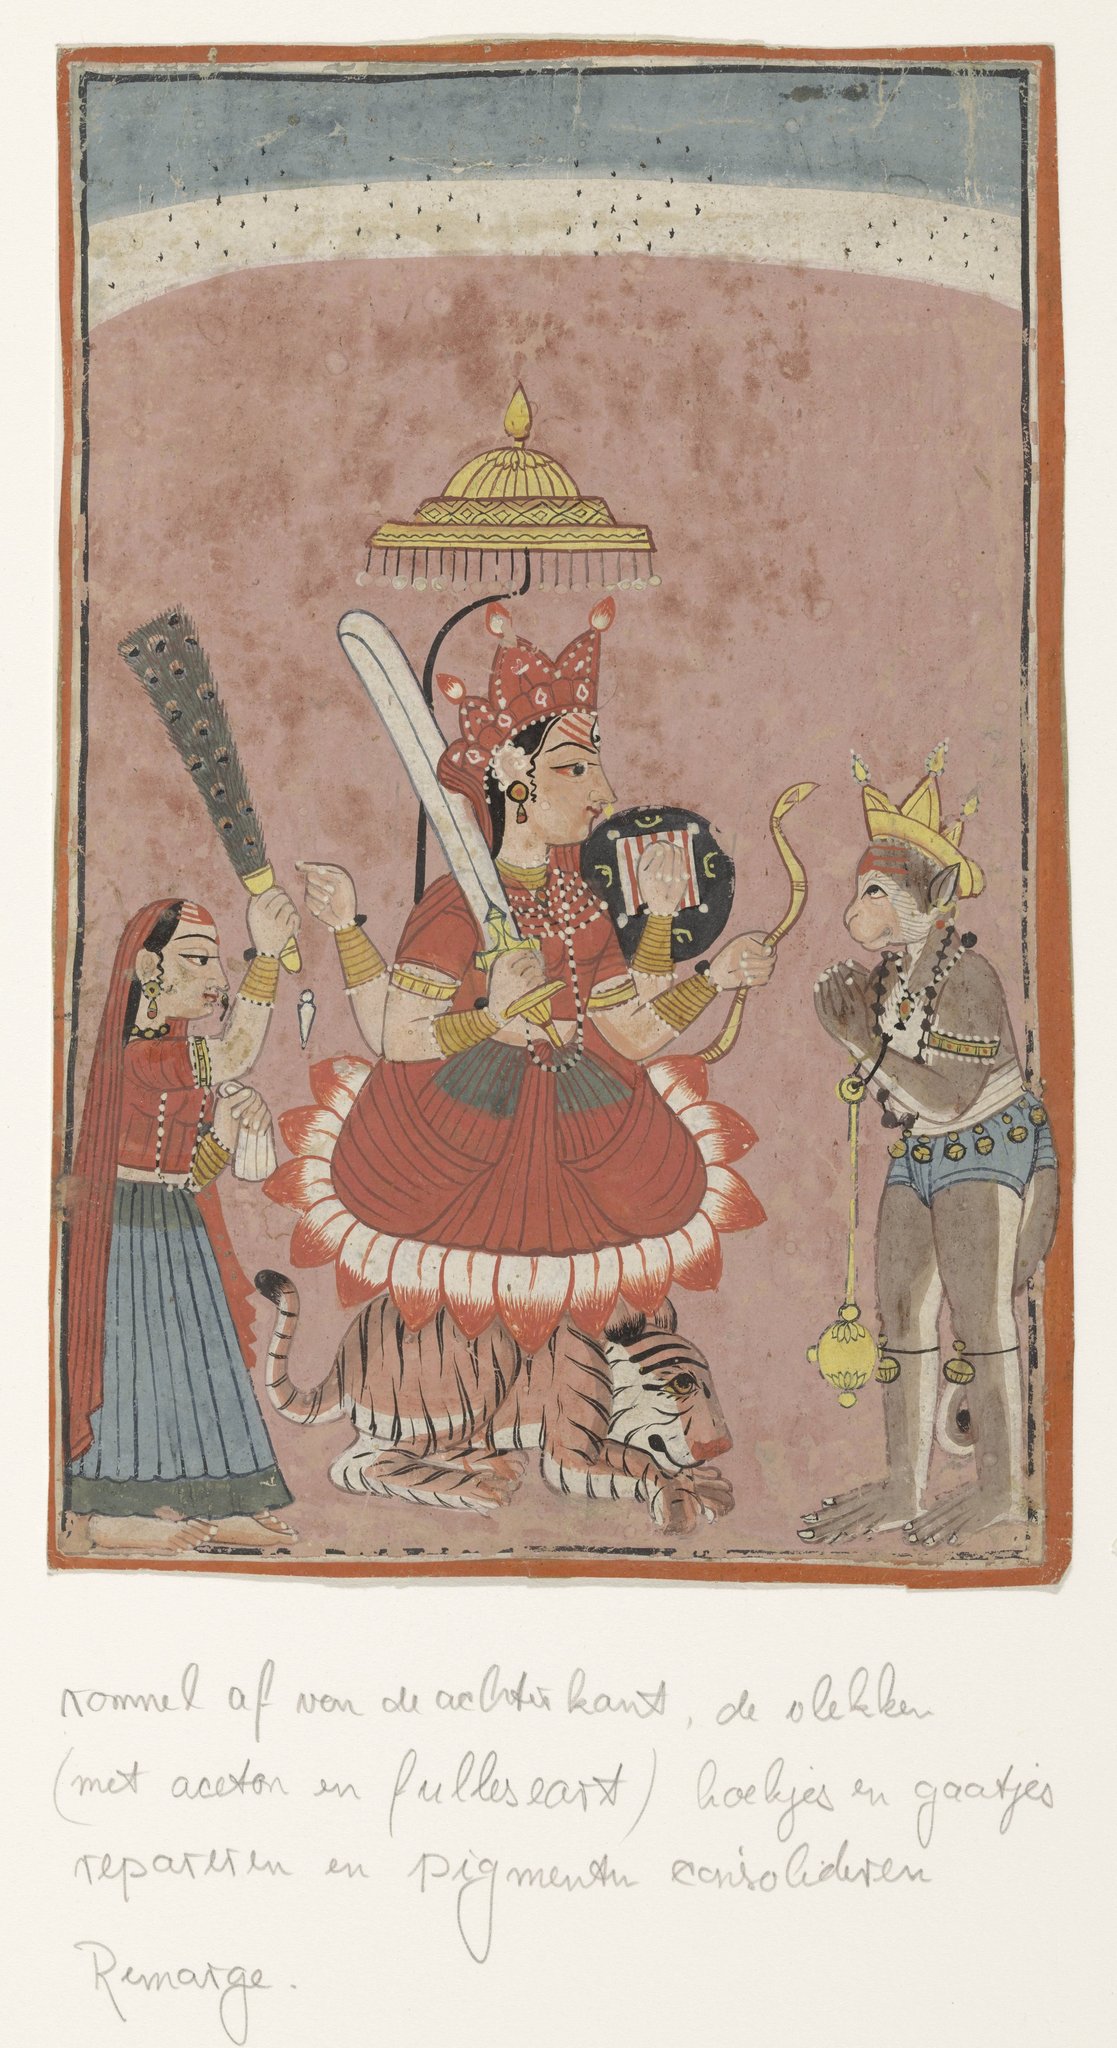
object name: indian miniature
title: Godin Durga en Hanuman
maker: Anonymous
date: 1760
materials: paper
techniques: brush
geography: mandi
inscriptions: inscription: ‘.’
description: Op een tijger staat de godin Durga, rechts voor haar staat de halfgod met aapgezicht Hanuman met gevouwen handen, achter haar een dienares die haar koelte toewuift. Rond de voorstelling een zwarte en witte kaderlijn en smalle oranje-rode rand; beschadigd.